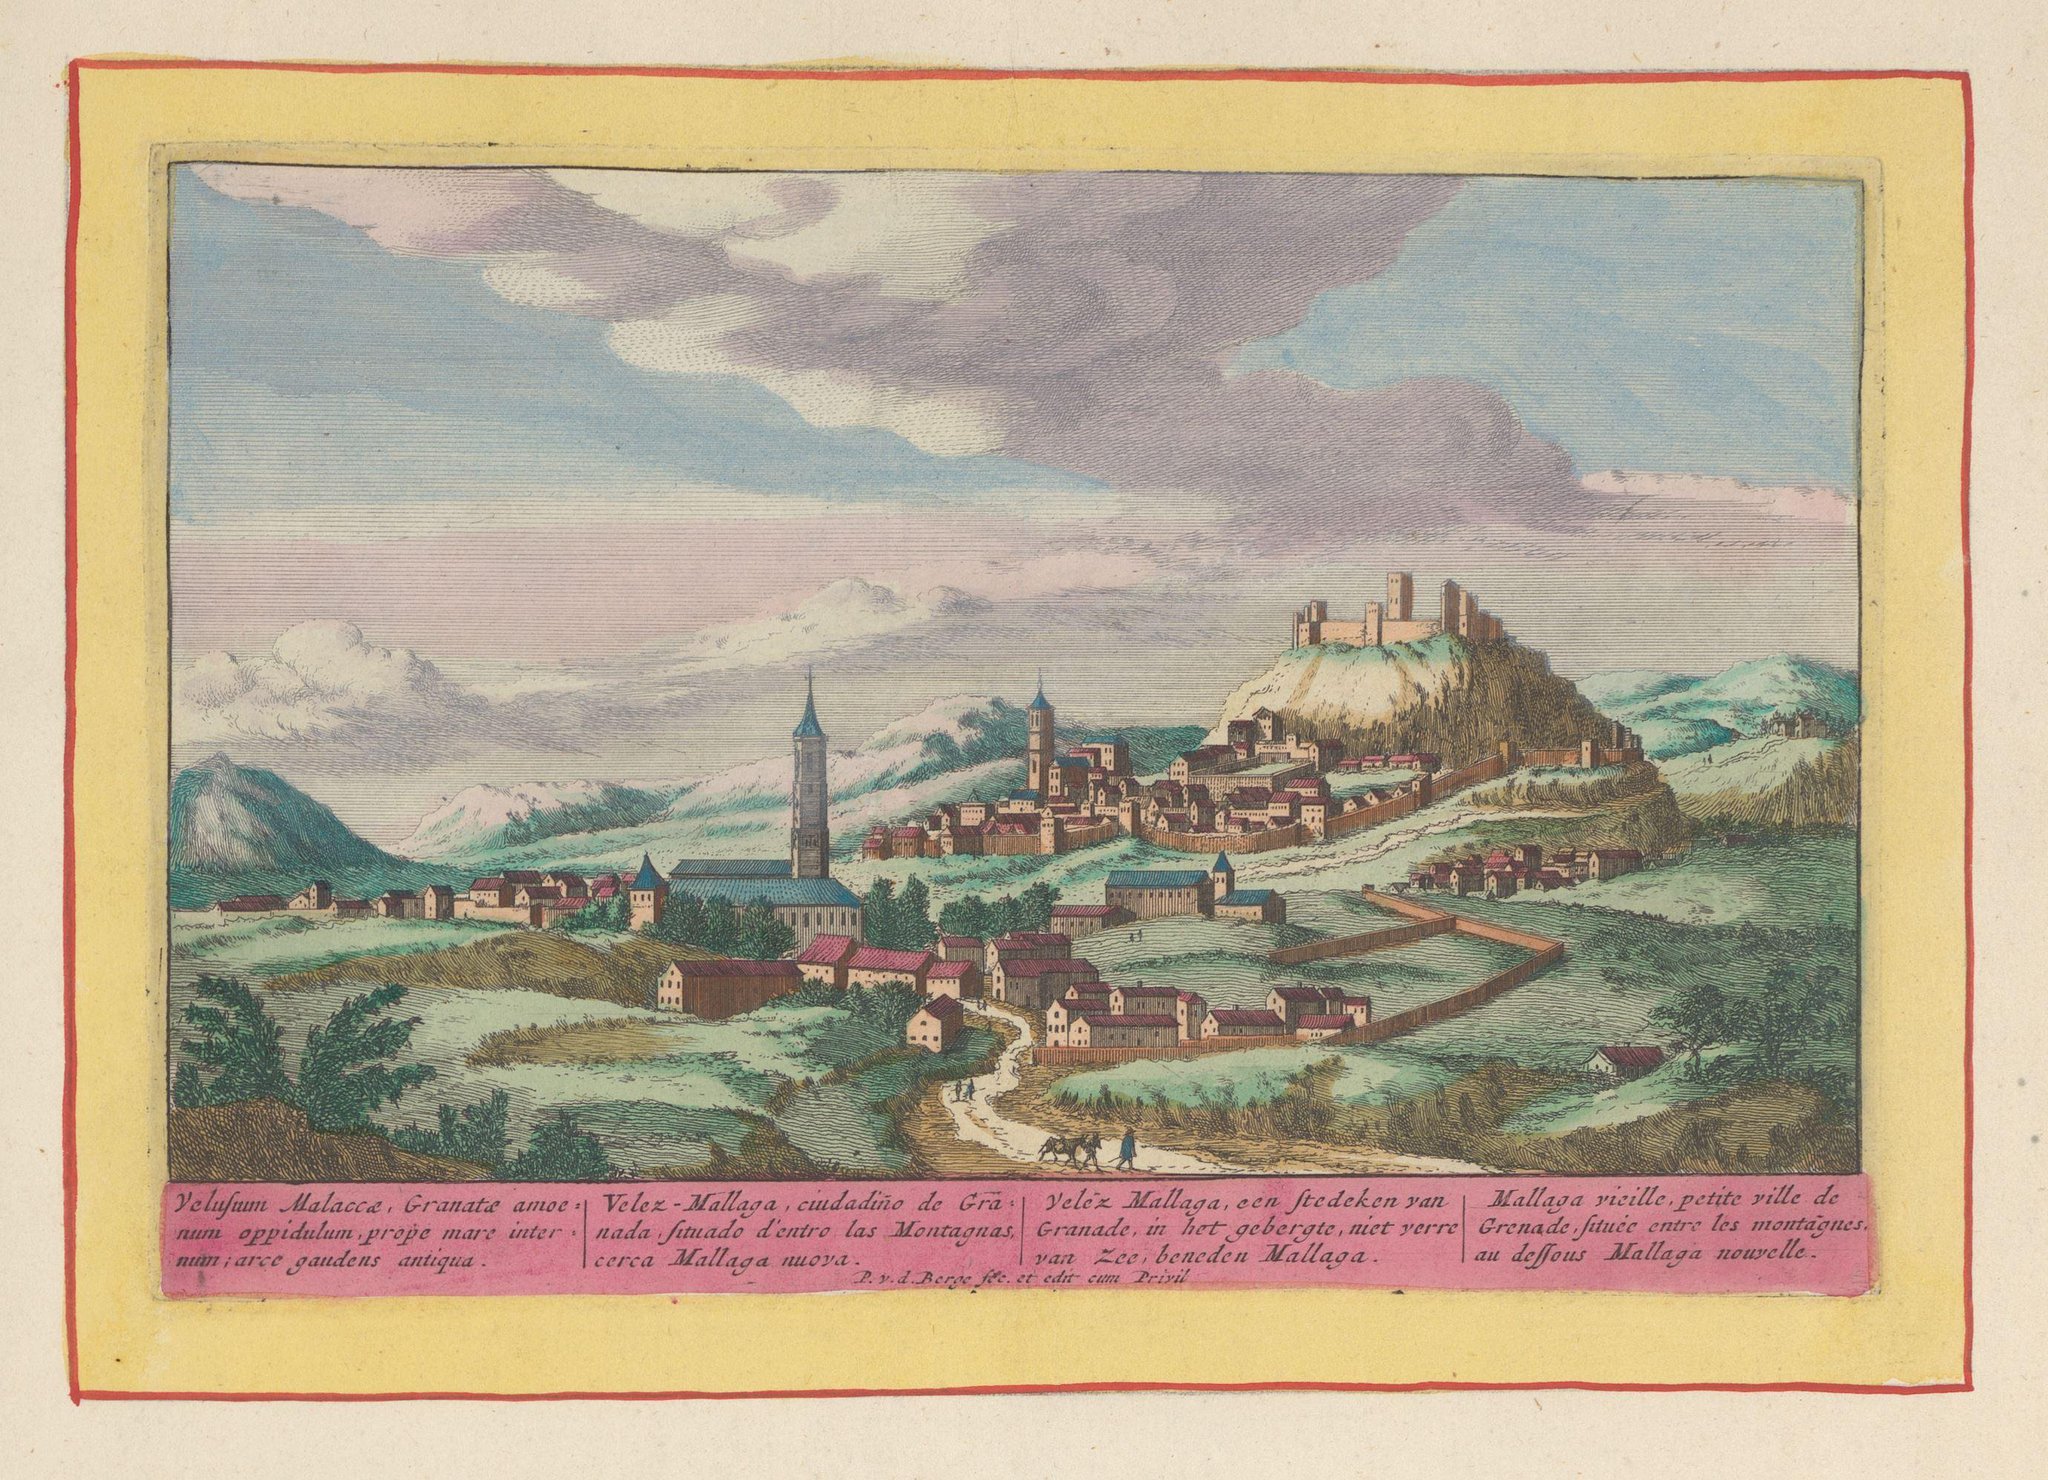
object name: album leaf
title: Vélez Mallaga, een stedeken van Granade, in het gebergte, niet verre van Zee, beneden Mallaga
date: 1694-1737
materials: paper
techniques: etching, hand coloring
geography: the hague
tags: prospect of village, silhouette of village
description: Prent uit: Theatrum Hispaniæ, exhibens regni urbes, villas ac viridaria magis illustria. Het aanmerkelykste en voortreffelykste in Spanjen (...). Amsterdam: Pieter van den Berge, ca. 1694-1737.